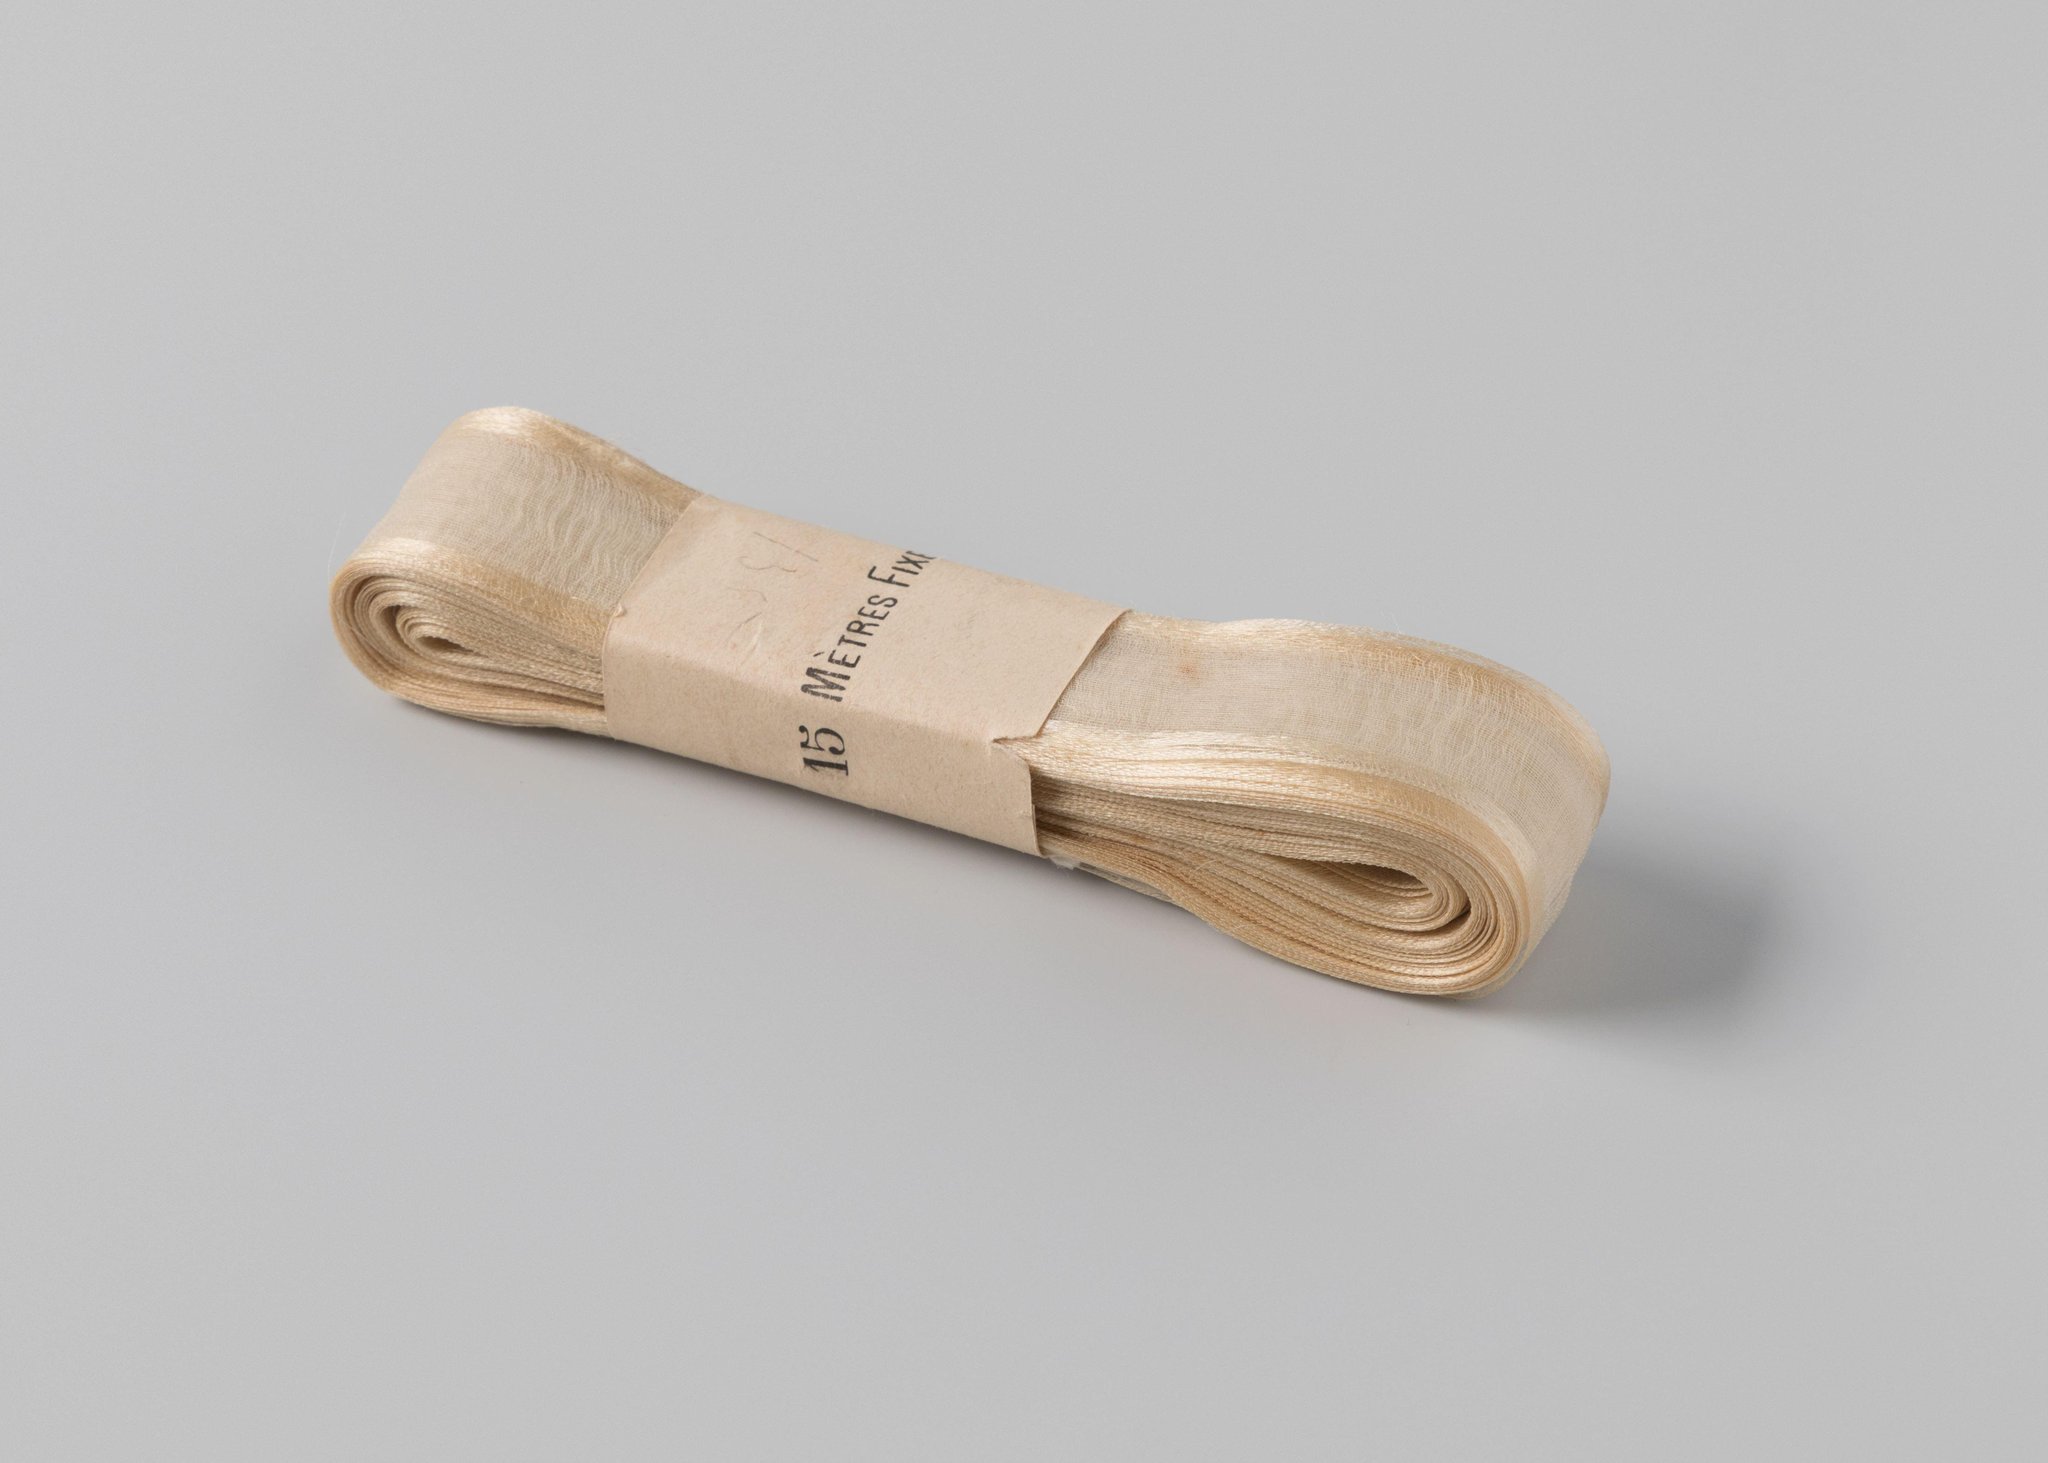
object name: ribbon material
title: Lint van crèmekleurig gaas van 15 meter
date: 1900-1915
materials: textile, silk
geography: france